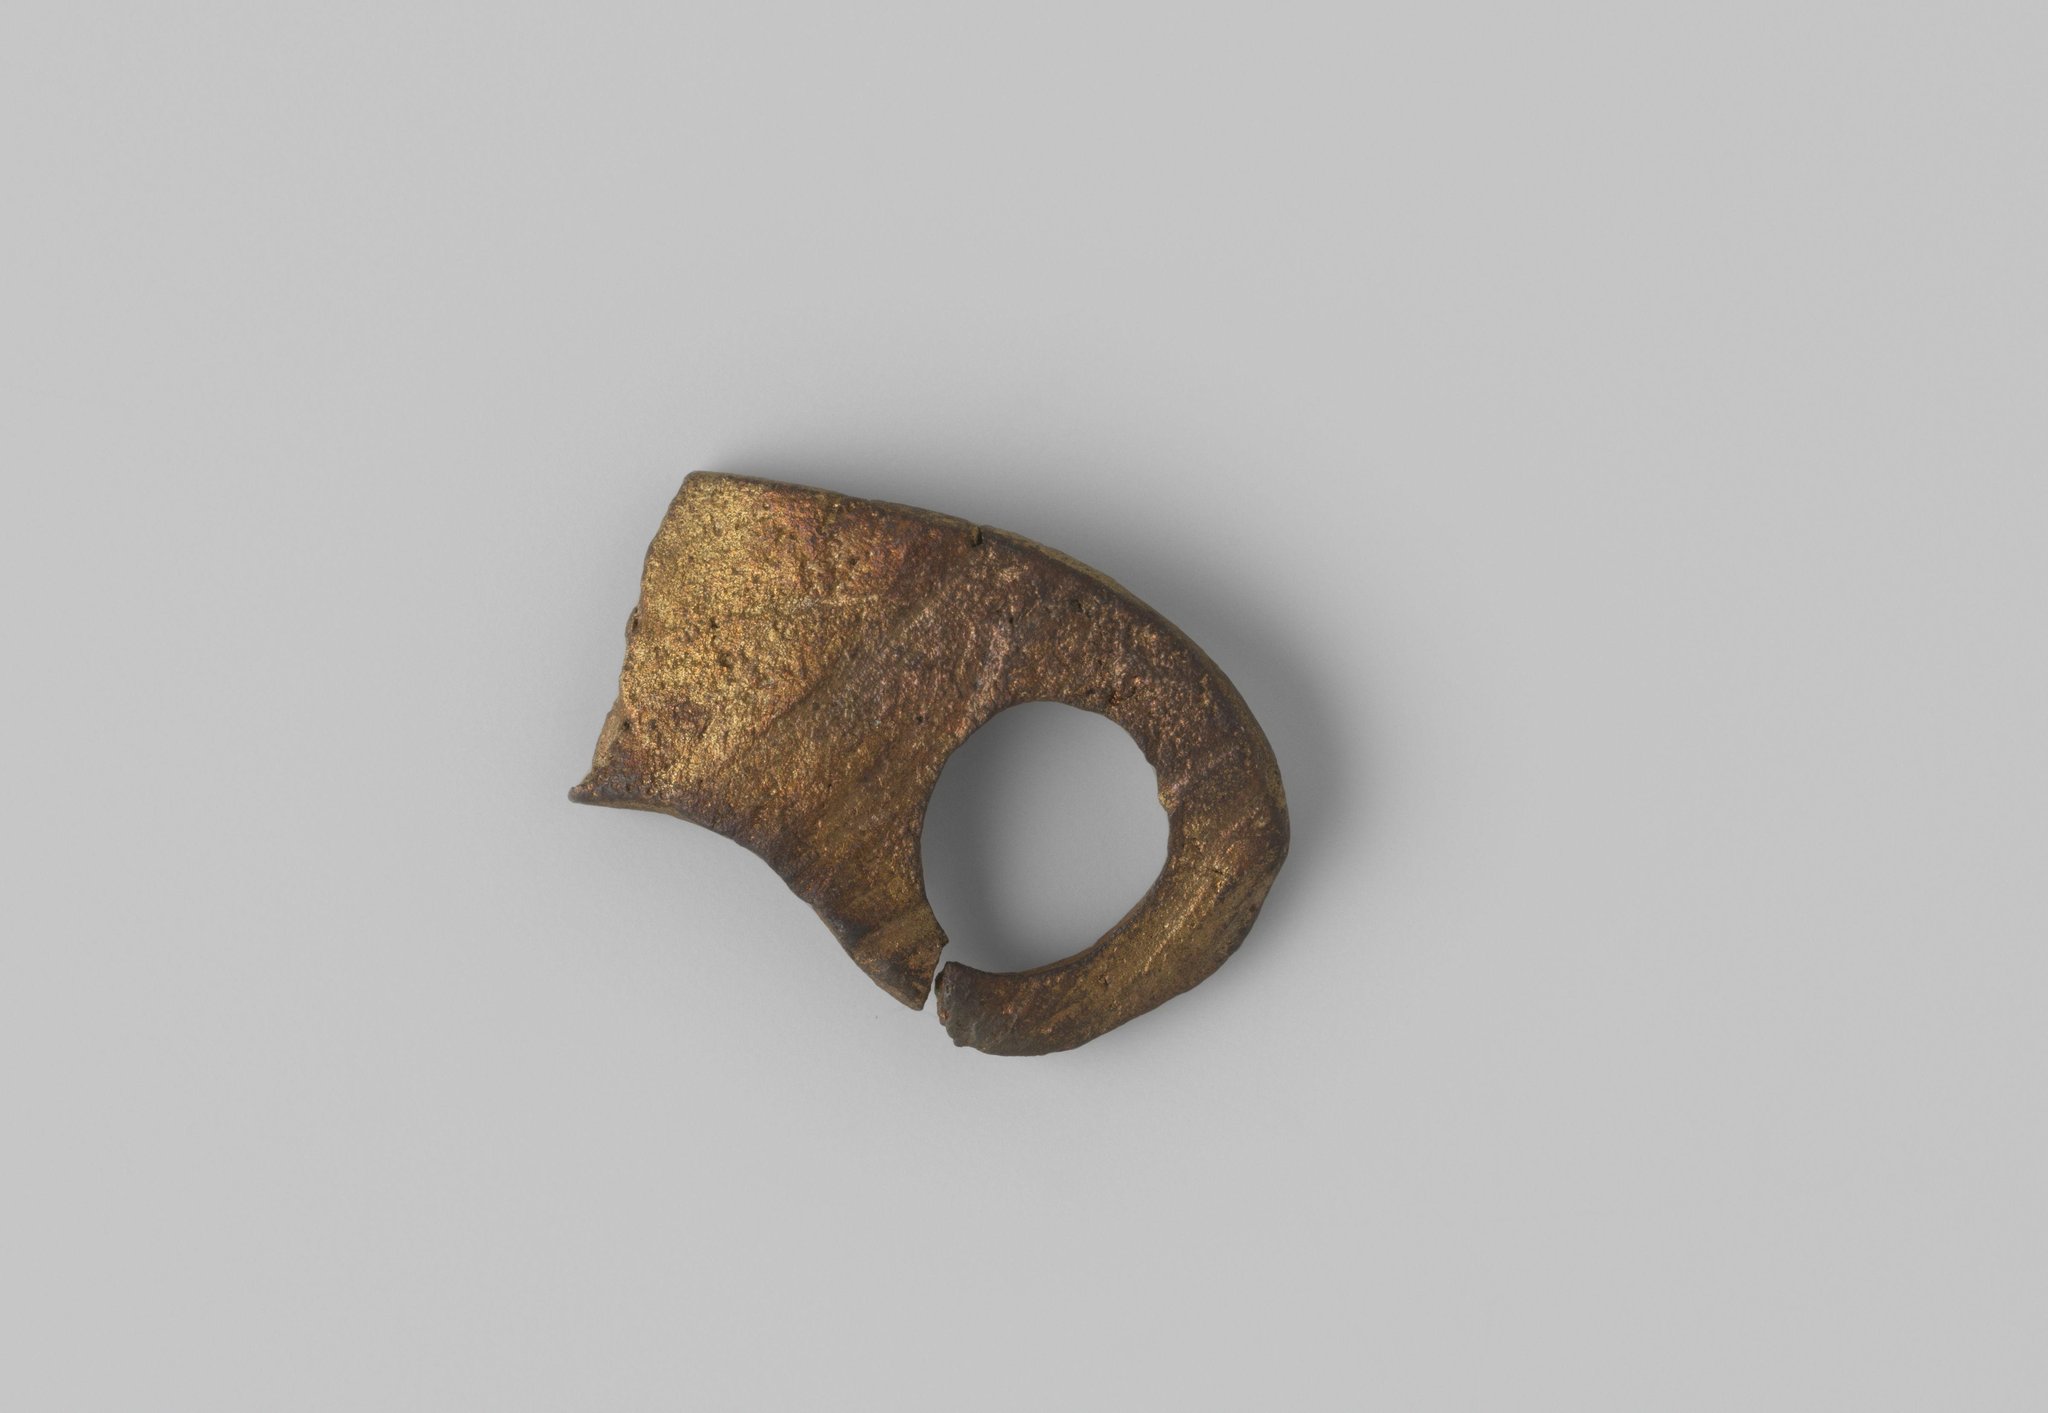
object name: musket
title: Fragment schroefplaat van een musket uit het wrak van de Oost-Indiëvaarder Hollandia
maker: Anonymous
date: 1700-1743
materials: copper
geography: netherlands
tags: verenigde oostindische compagnie, hollandia (schip), annet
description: Fragm, left eye, id. NG 1978-74H986, side plate.